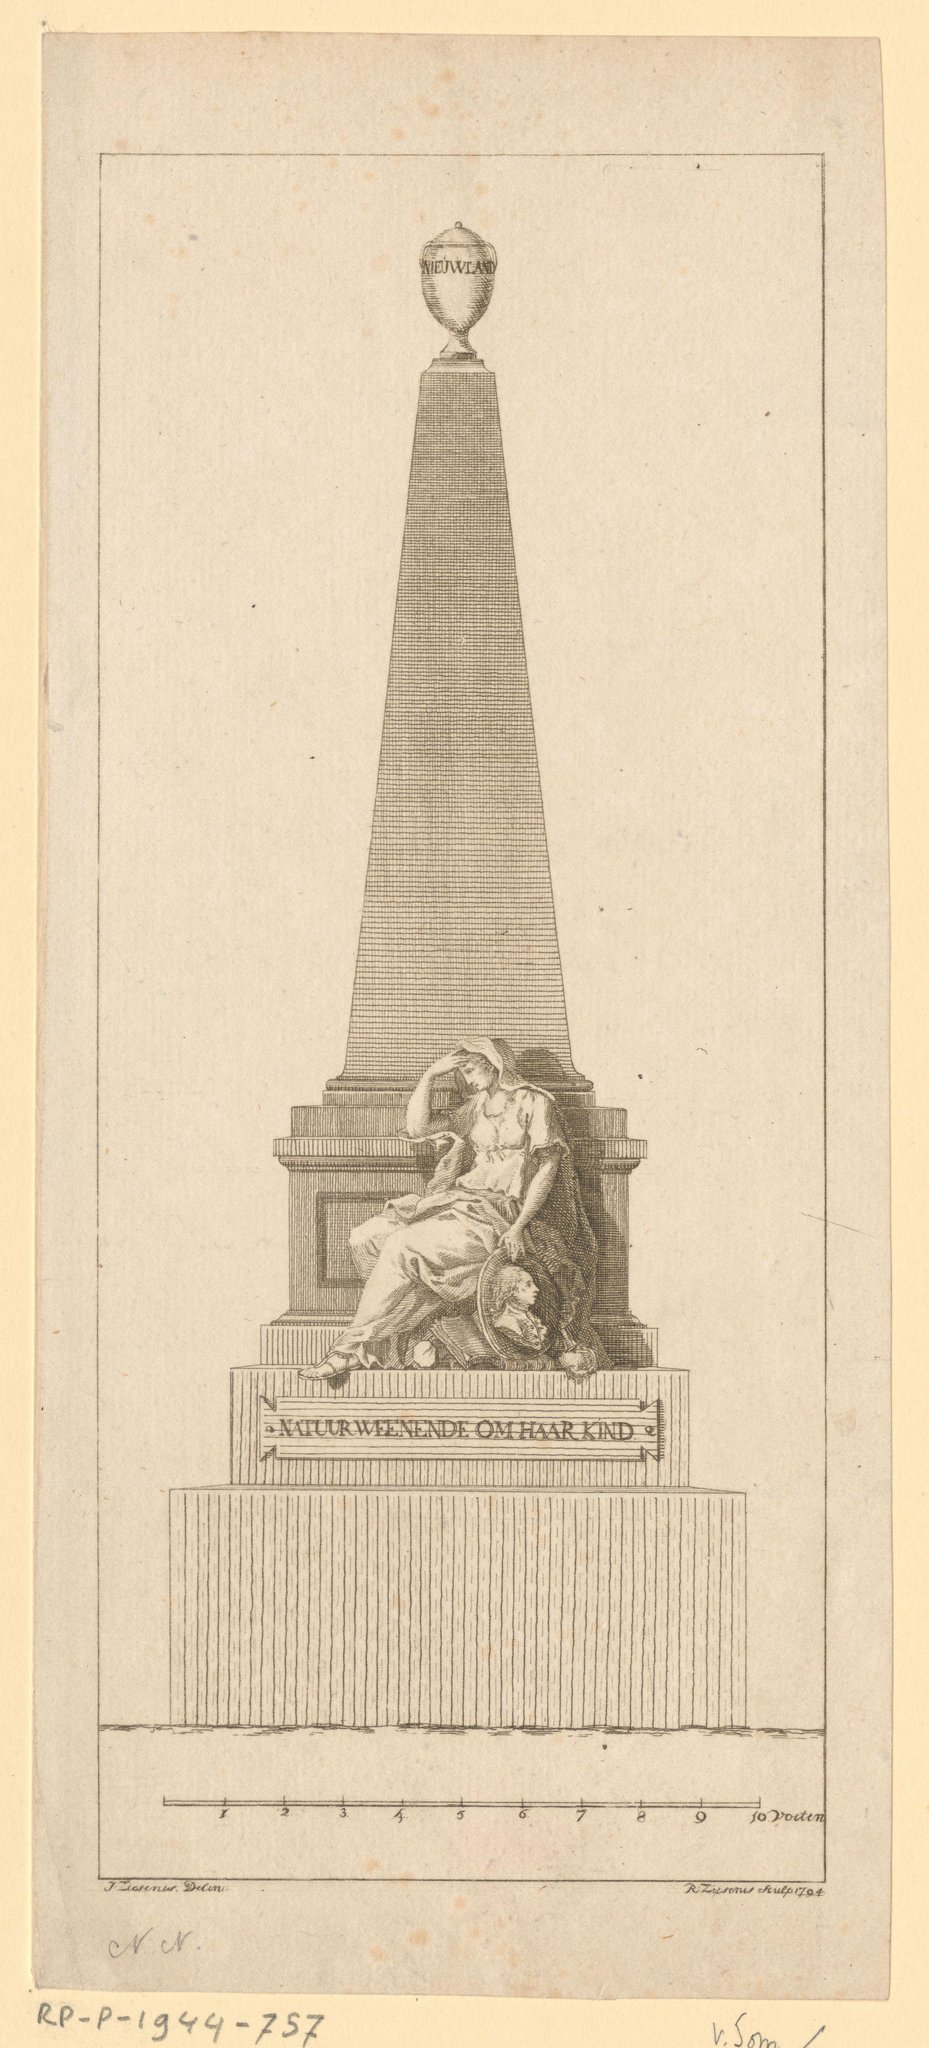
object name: print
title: Monument ter nagedachtenis aan Pieter Nieuwland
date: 1794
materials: paper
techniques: etching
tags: historical persons, monument, statue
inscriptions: collector's mark: Lugt 2228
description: Prent waarschijnlijk uit: Mitchell, J.P. Iets ter nagedachtenis van Pieter Nieuwland. Amsterdam: weduwe Jan Dóll, 1794.